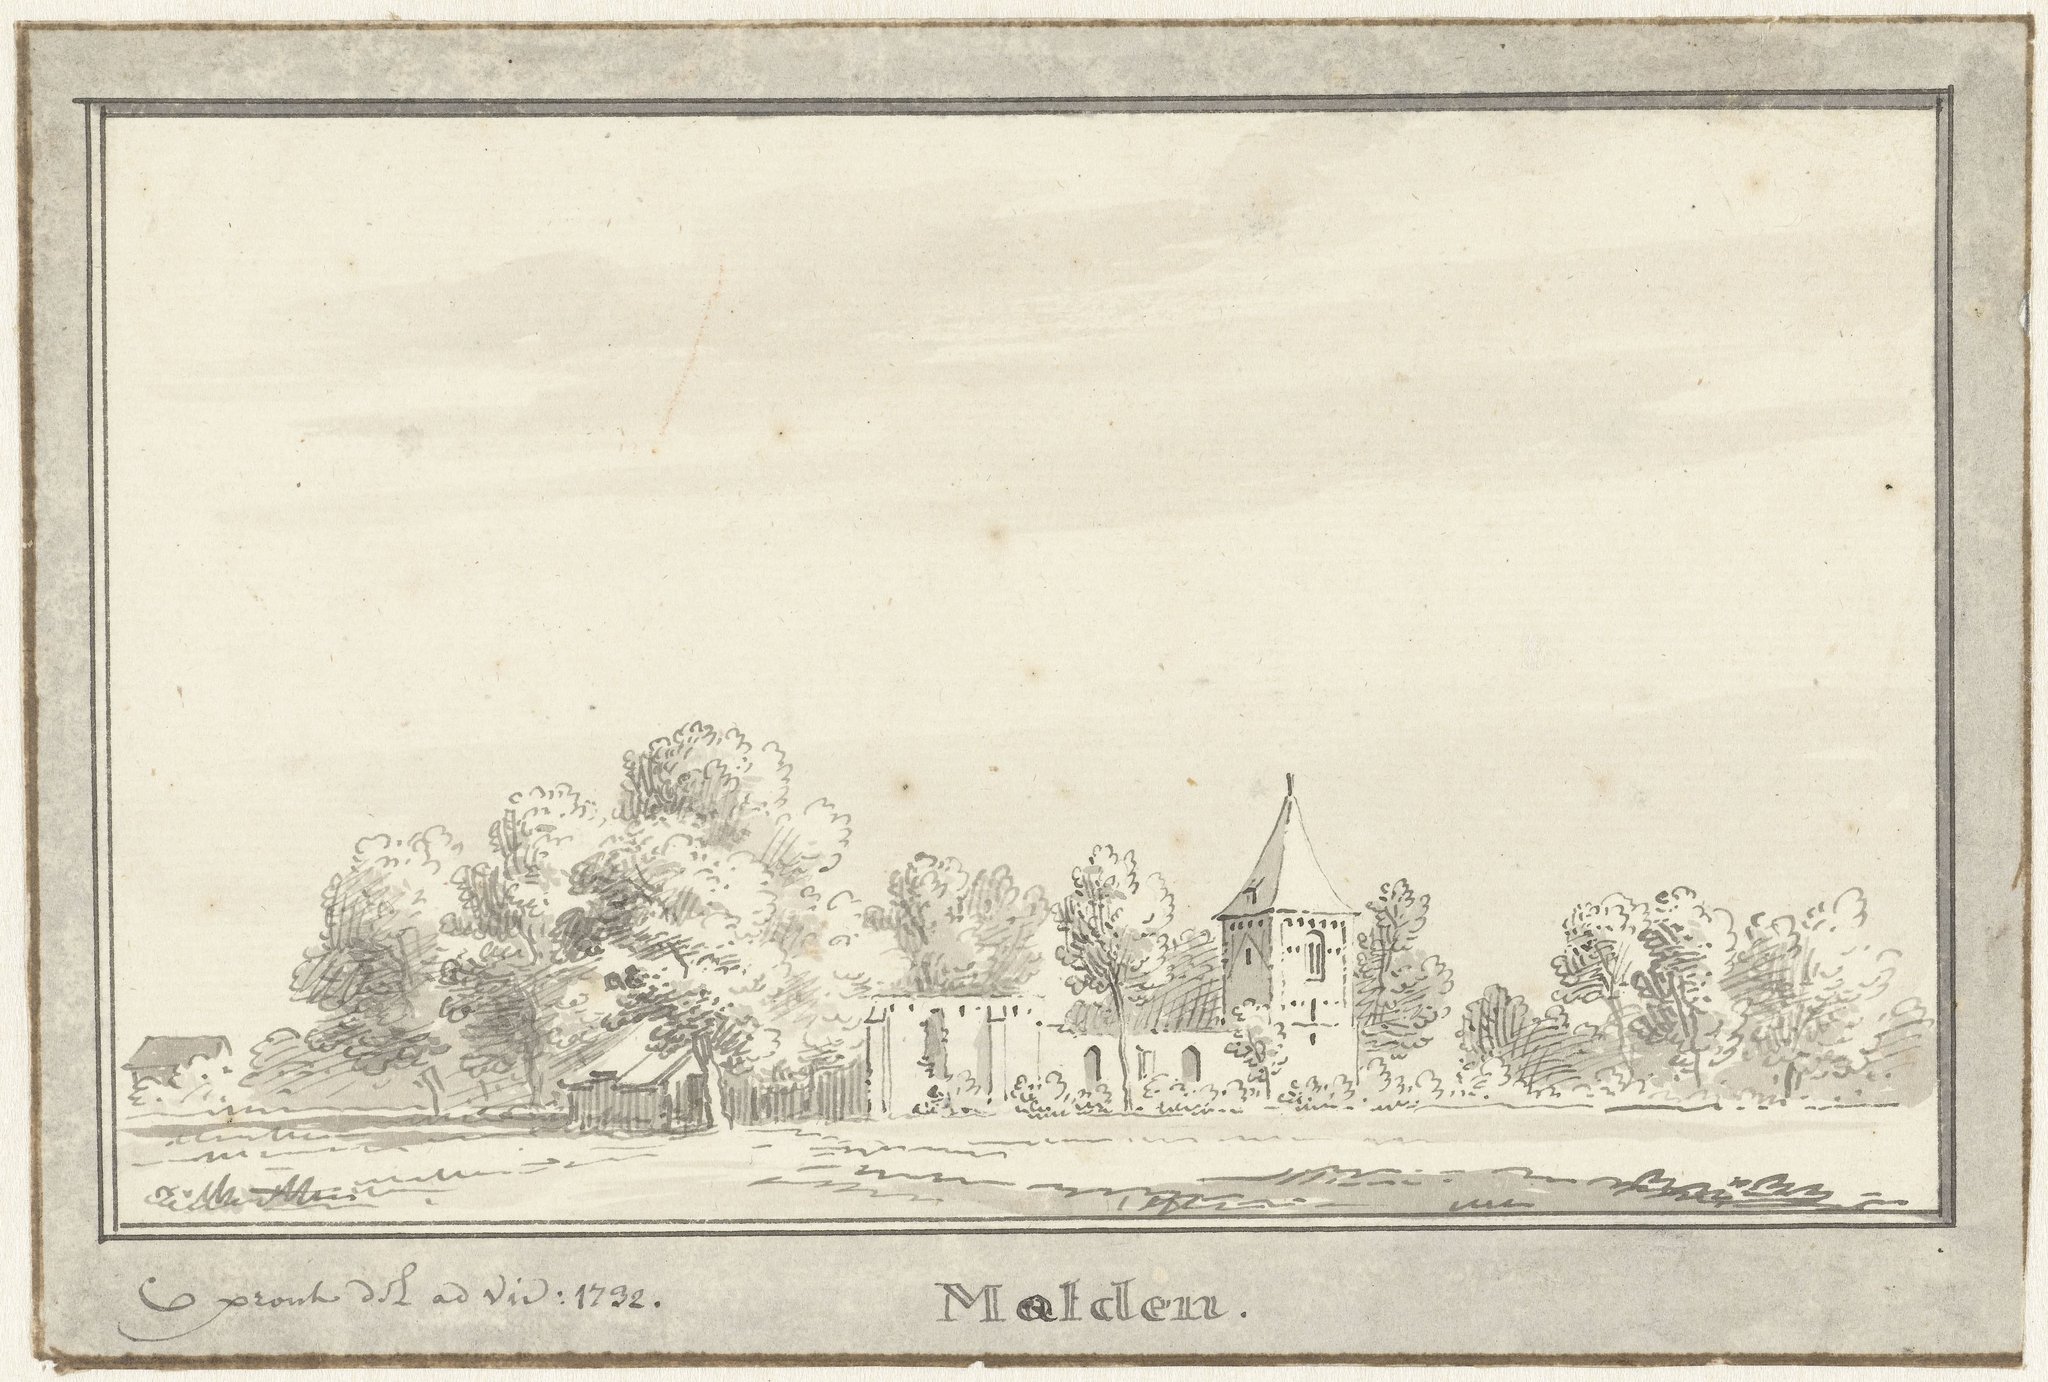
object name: drawing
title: Malden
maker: cornelis pronk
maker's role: draughtsman, painter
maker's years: 1691-1759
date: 1732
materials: ink, paper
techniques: brush, pen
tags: church (exterior)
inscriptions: caption: ‘C: pronk del ad viv: 1731 / Malden’